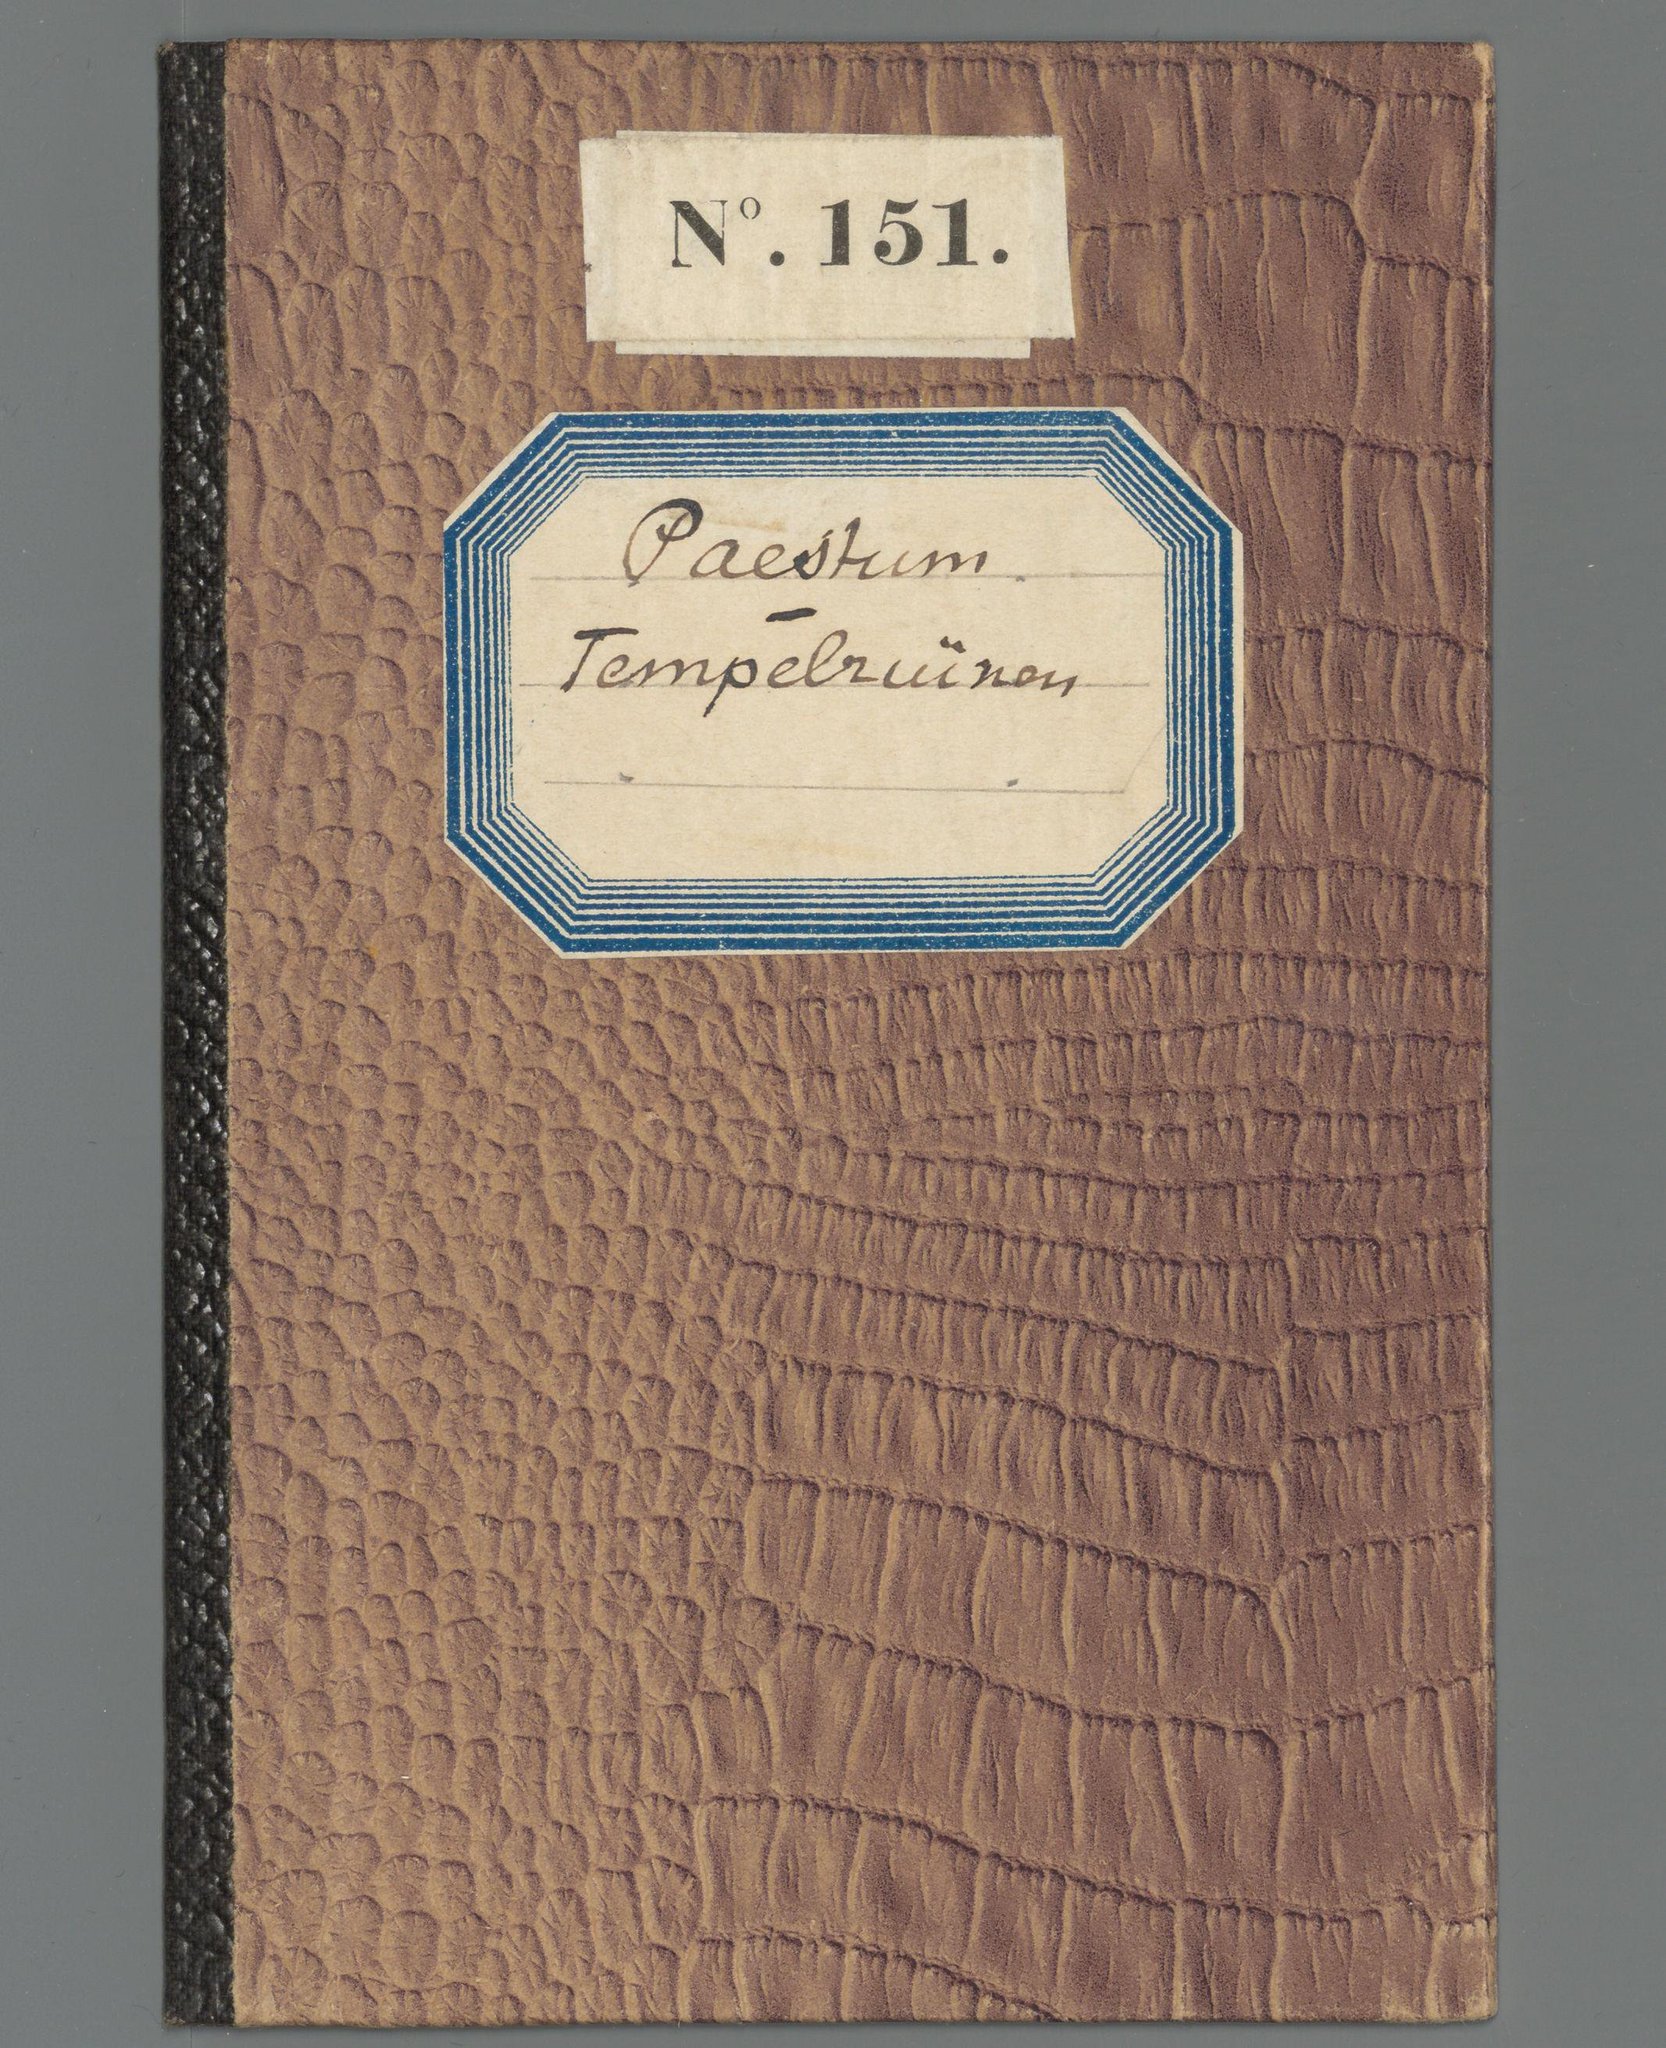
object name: wrapper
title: Paestum. Tempelruïnen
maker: Anonymous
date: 1900-1950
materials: cardboard, ink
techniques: pen